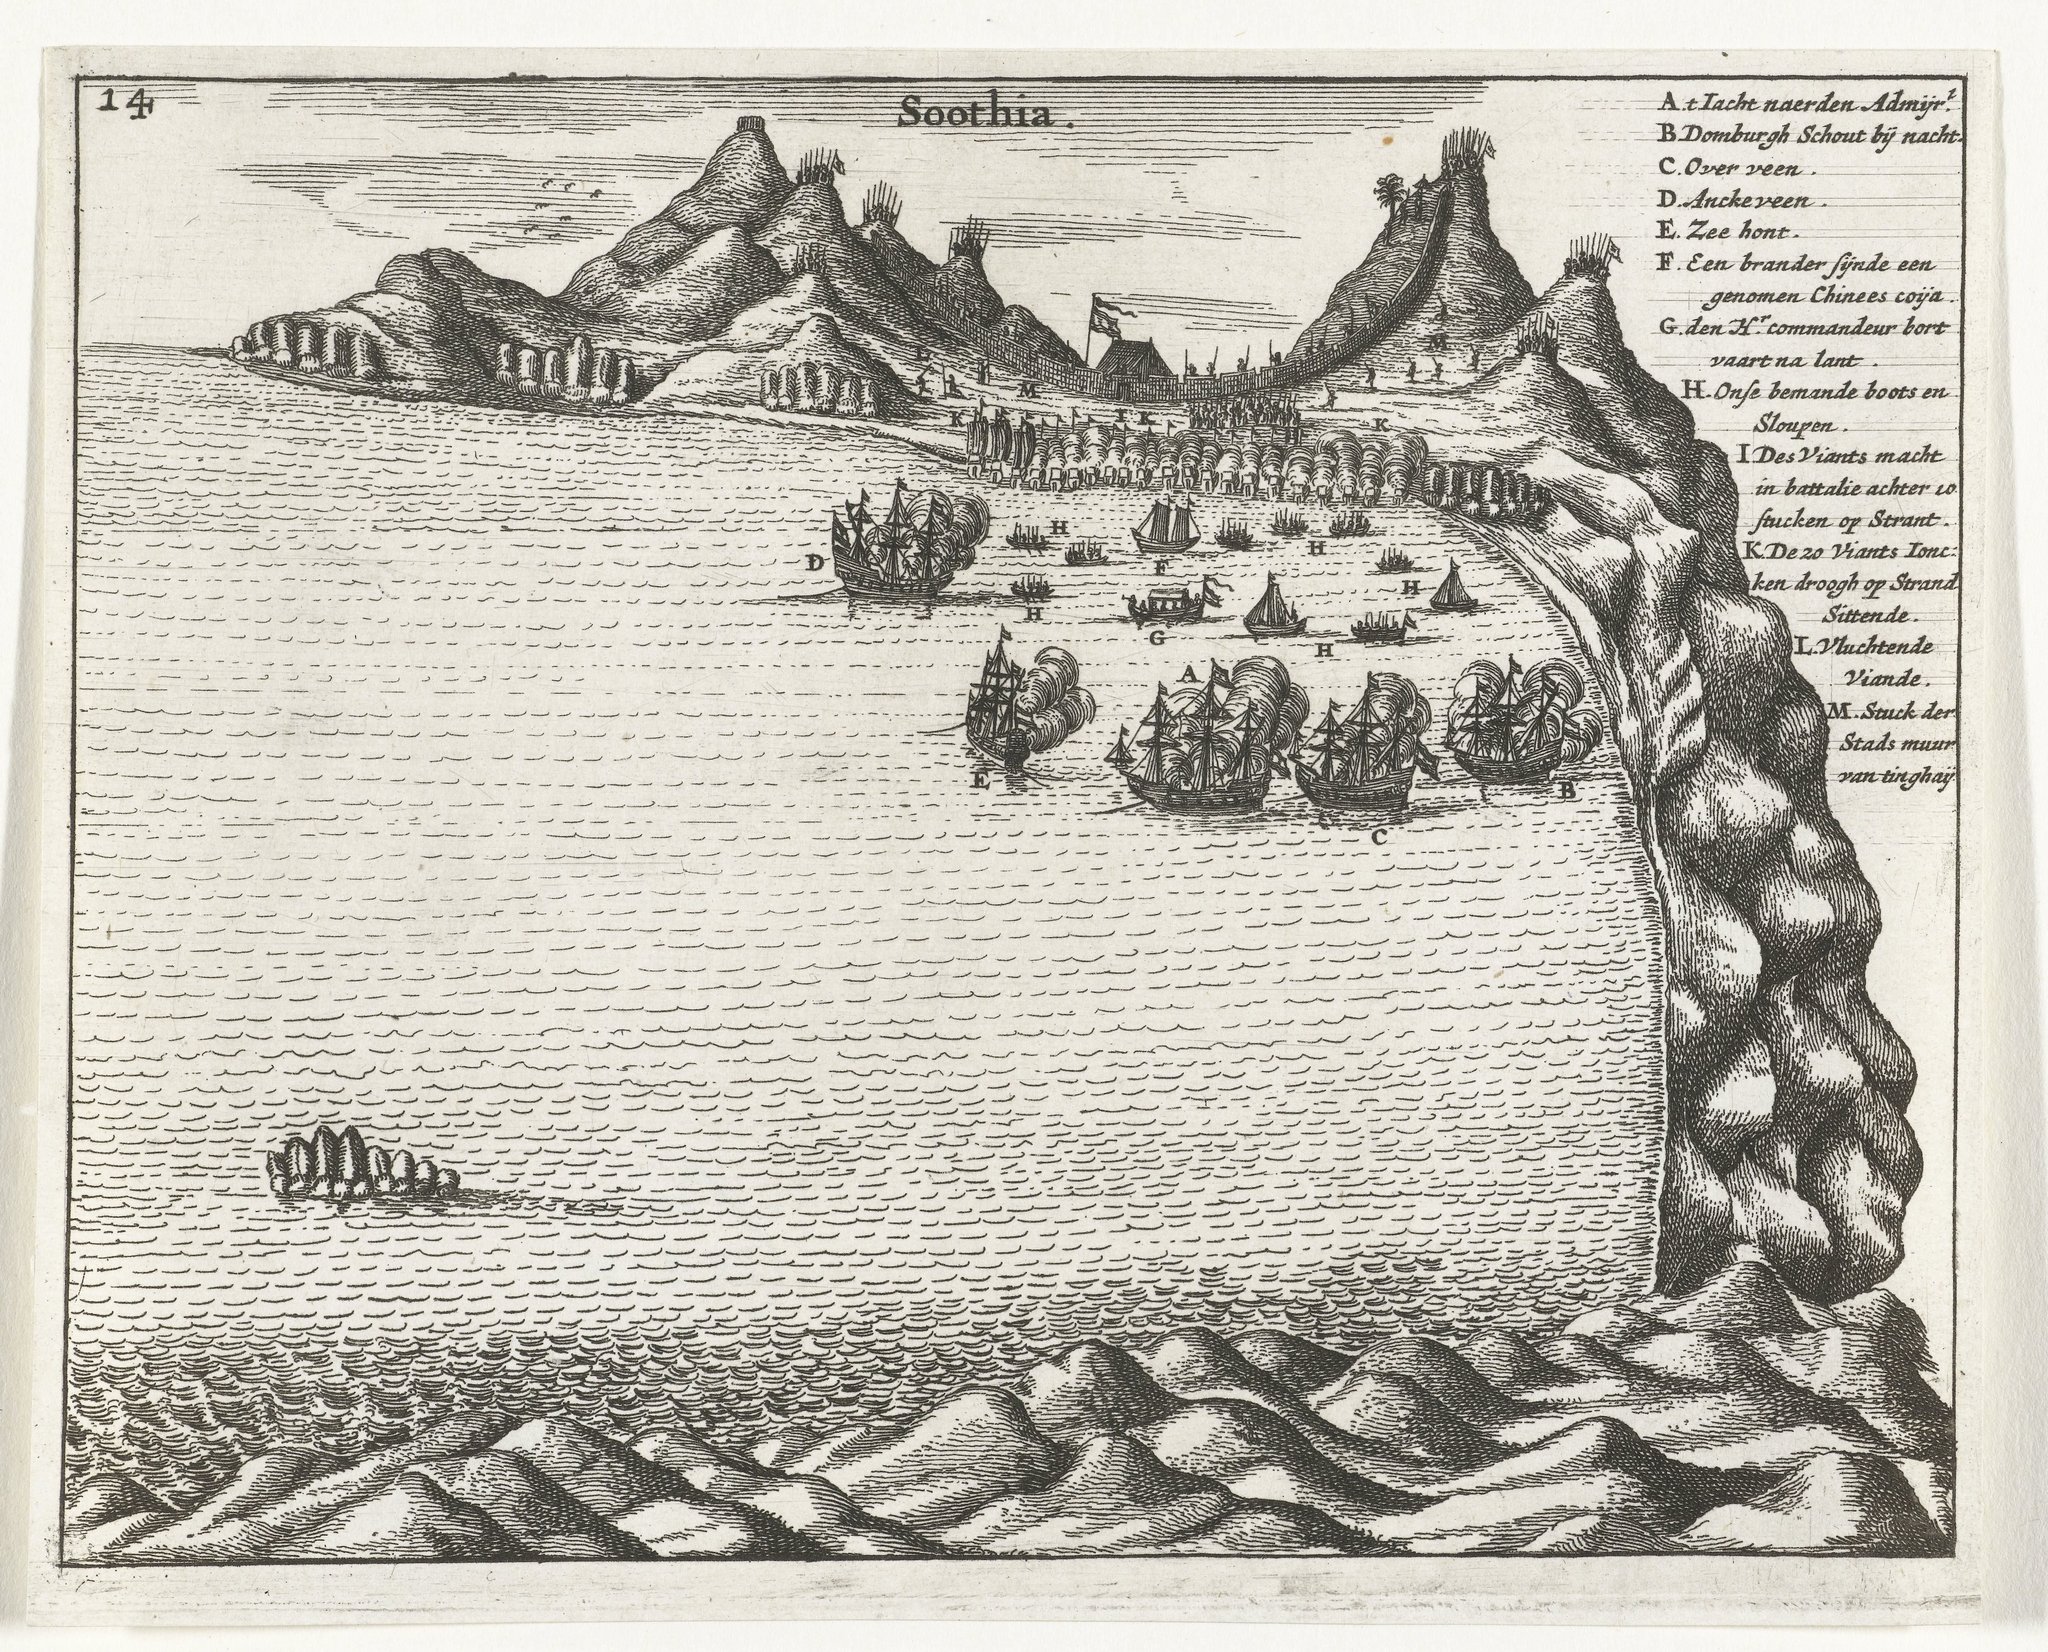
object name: print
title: Gevechten bij Soothia (China), 1662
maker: Anonymous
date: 1670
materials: paper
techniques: etching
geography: northern netherlands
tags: japan, sailing-ship, sailing-boat, battle (+ naval force), china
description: Nederlandse aanval op de Chinese stad Soothia (Xiaocheng), 8 augustus 1662. In verband met de expedities van de VOC van 1662-1665 onder leiding van Balthasar Bort tegen de Chinese krijgsheer Coxinga. Met rechts de legenda A-M. Gemerkt linksboven: 14.